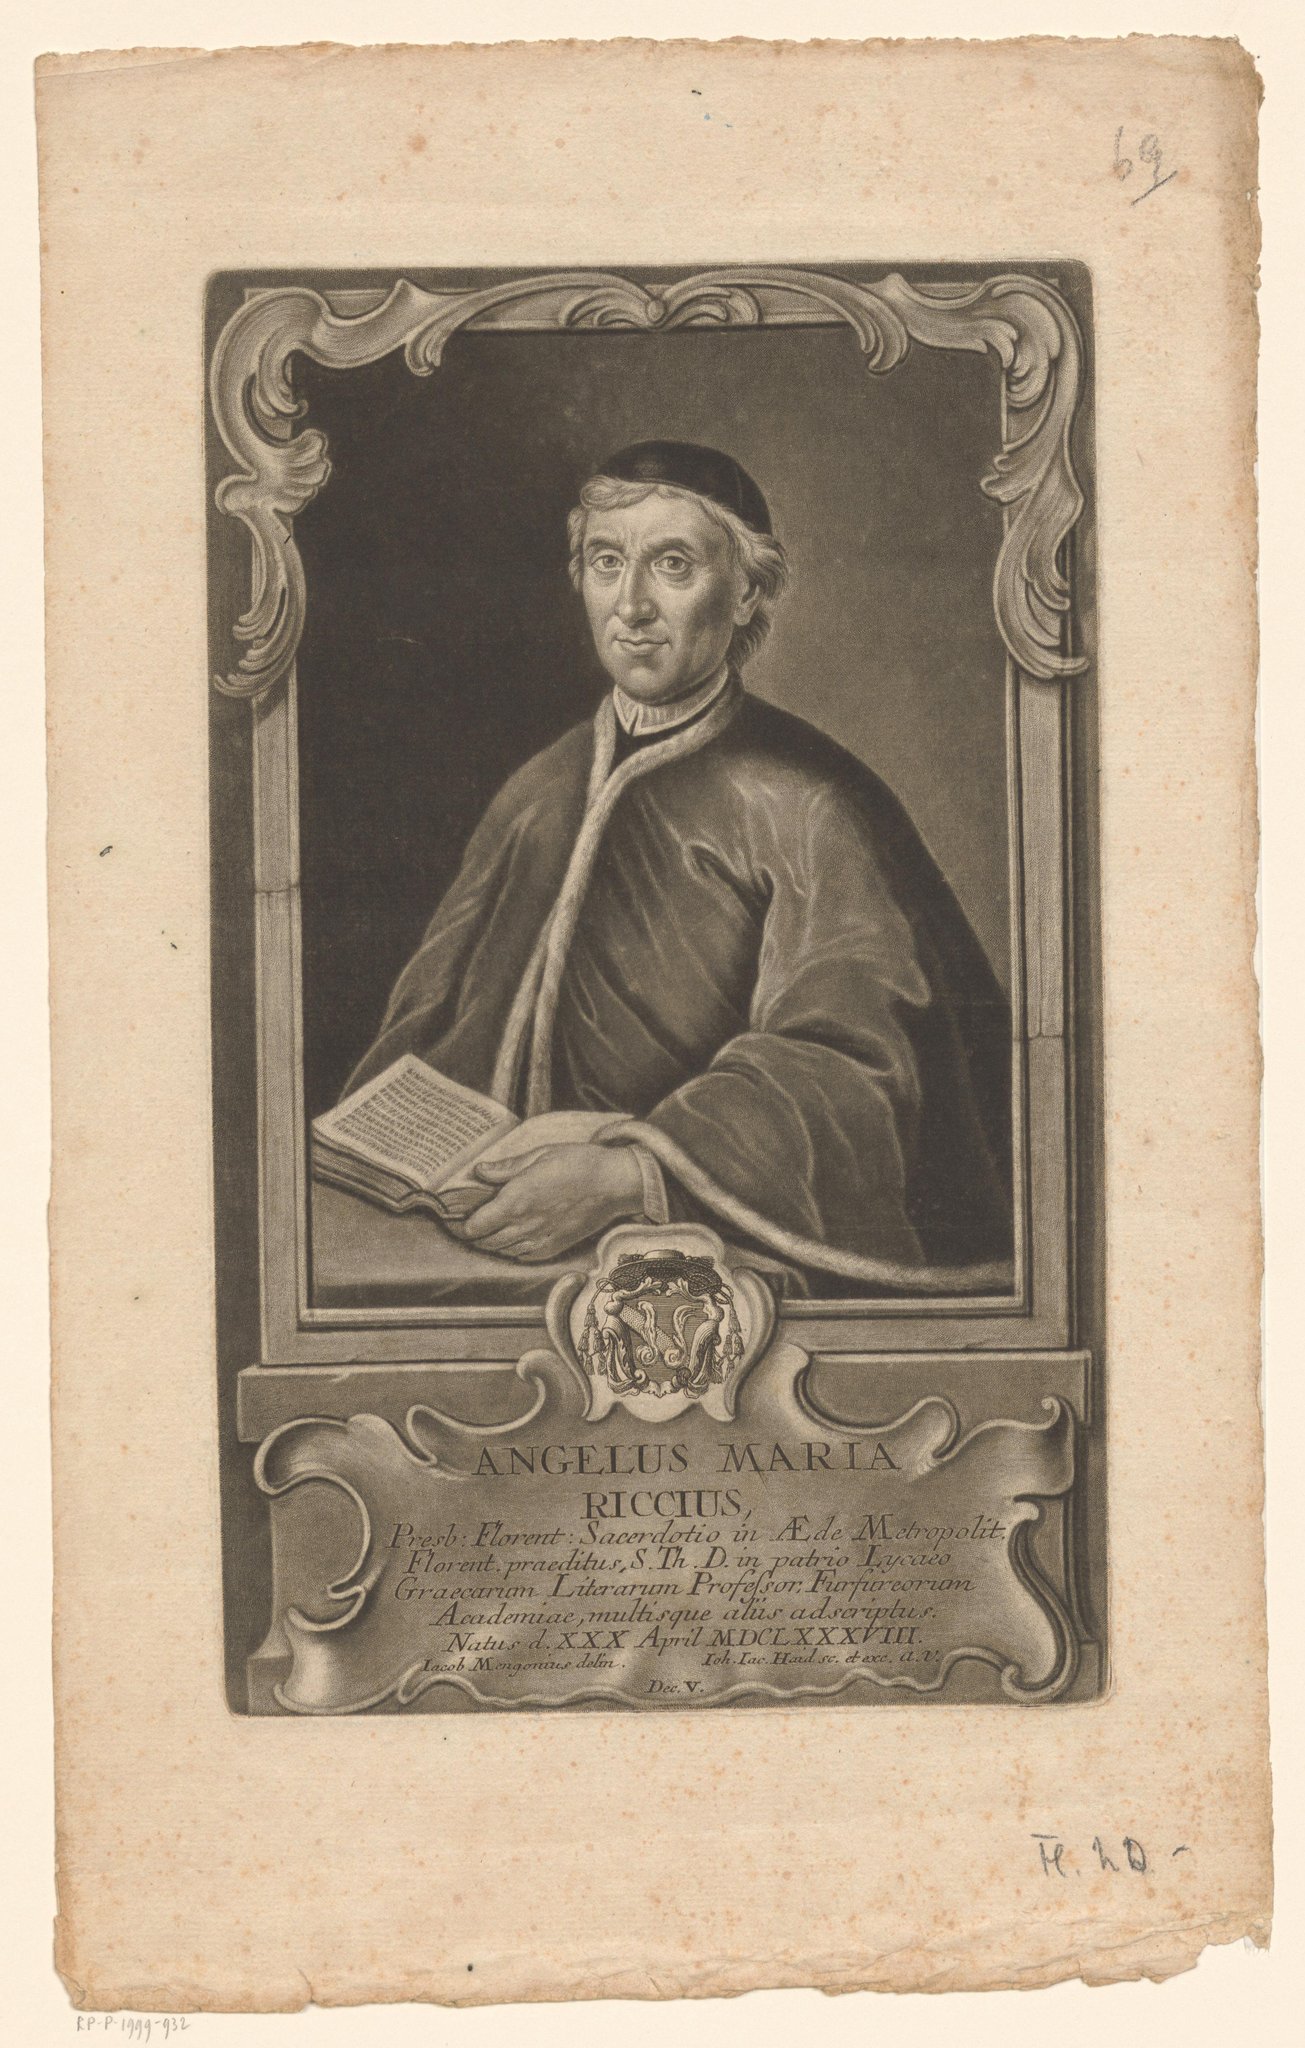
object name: print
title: Portret van Angelo Maria Ricci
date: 1746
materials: paper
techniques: engraving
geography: augsburg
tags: historical persons, book, armorial bearing, heraldry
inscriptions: collector's mark: Lugt 2228, collector's mark: Lugt 2760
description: Prent mogelijk uit: Brucker, Jacob. Bildersal heutiges Tages lebender und durch Gelahrheit berühmter Schrifftsteller. Augsburg: Johann Jacob Haid, 1746, dl. 1.